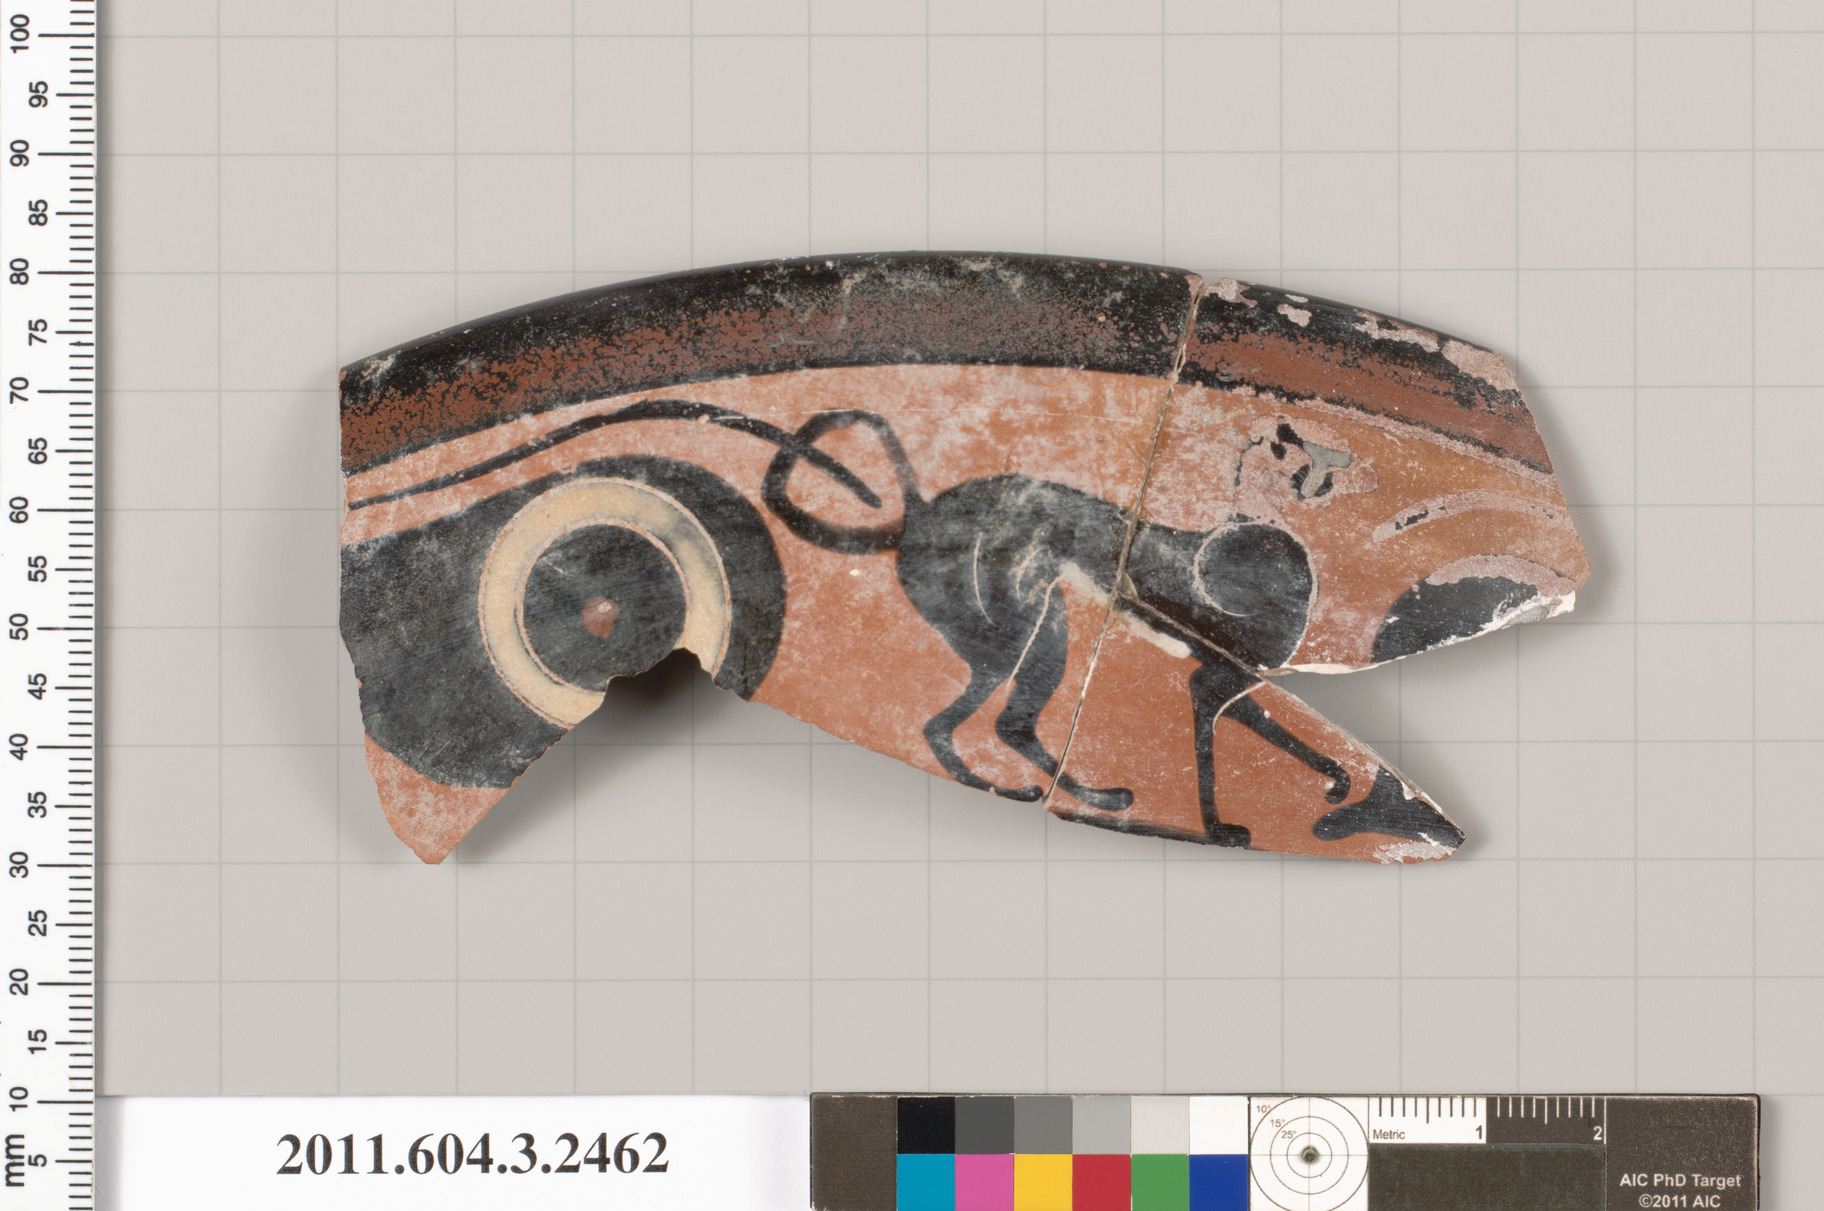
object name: kylix fragment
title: Terracotta rim fragment of a kylix: eye-cup (drinking cup)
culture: greek, attic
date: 525-501 BCE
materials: terracotta